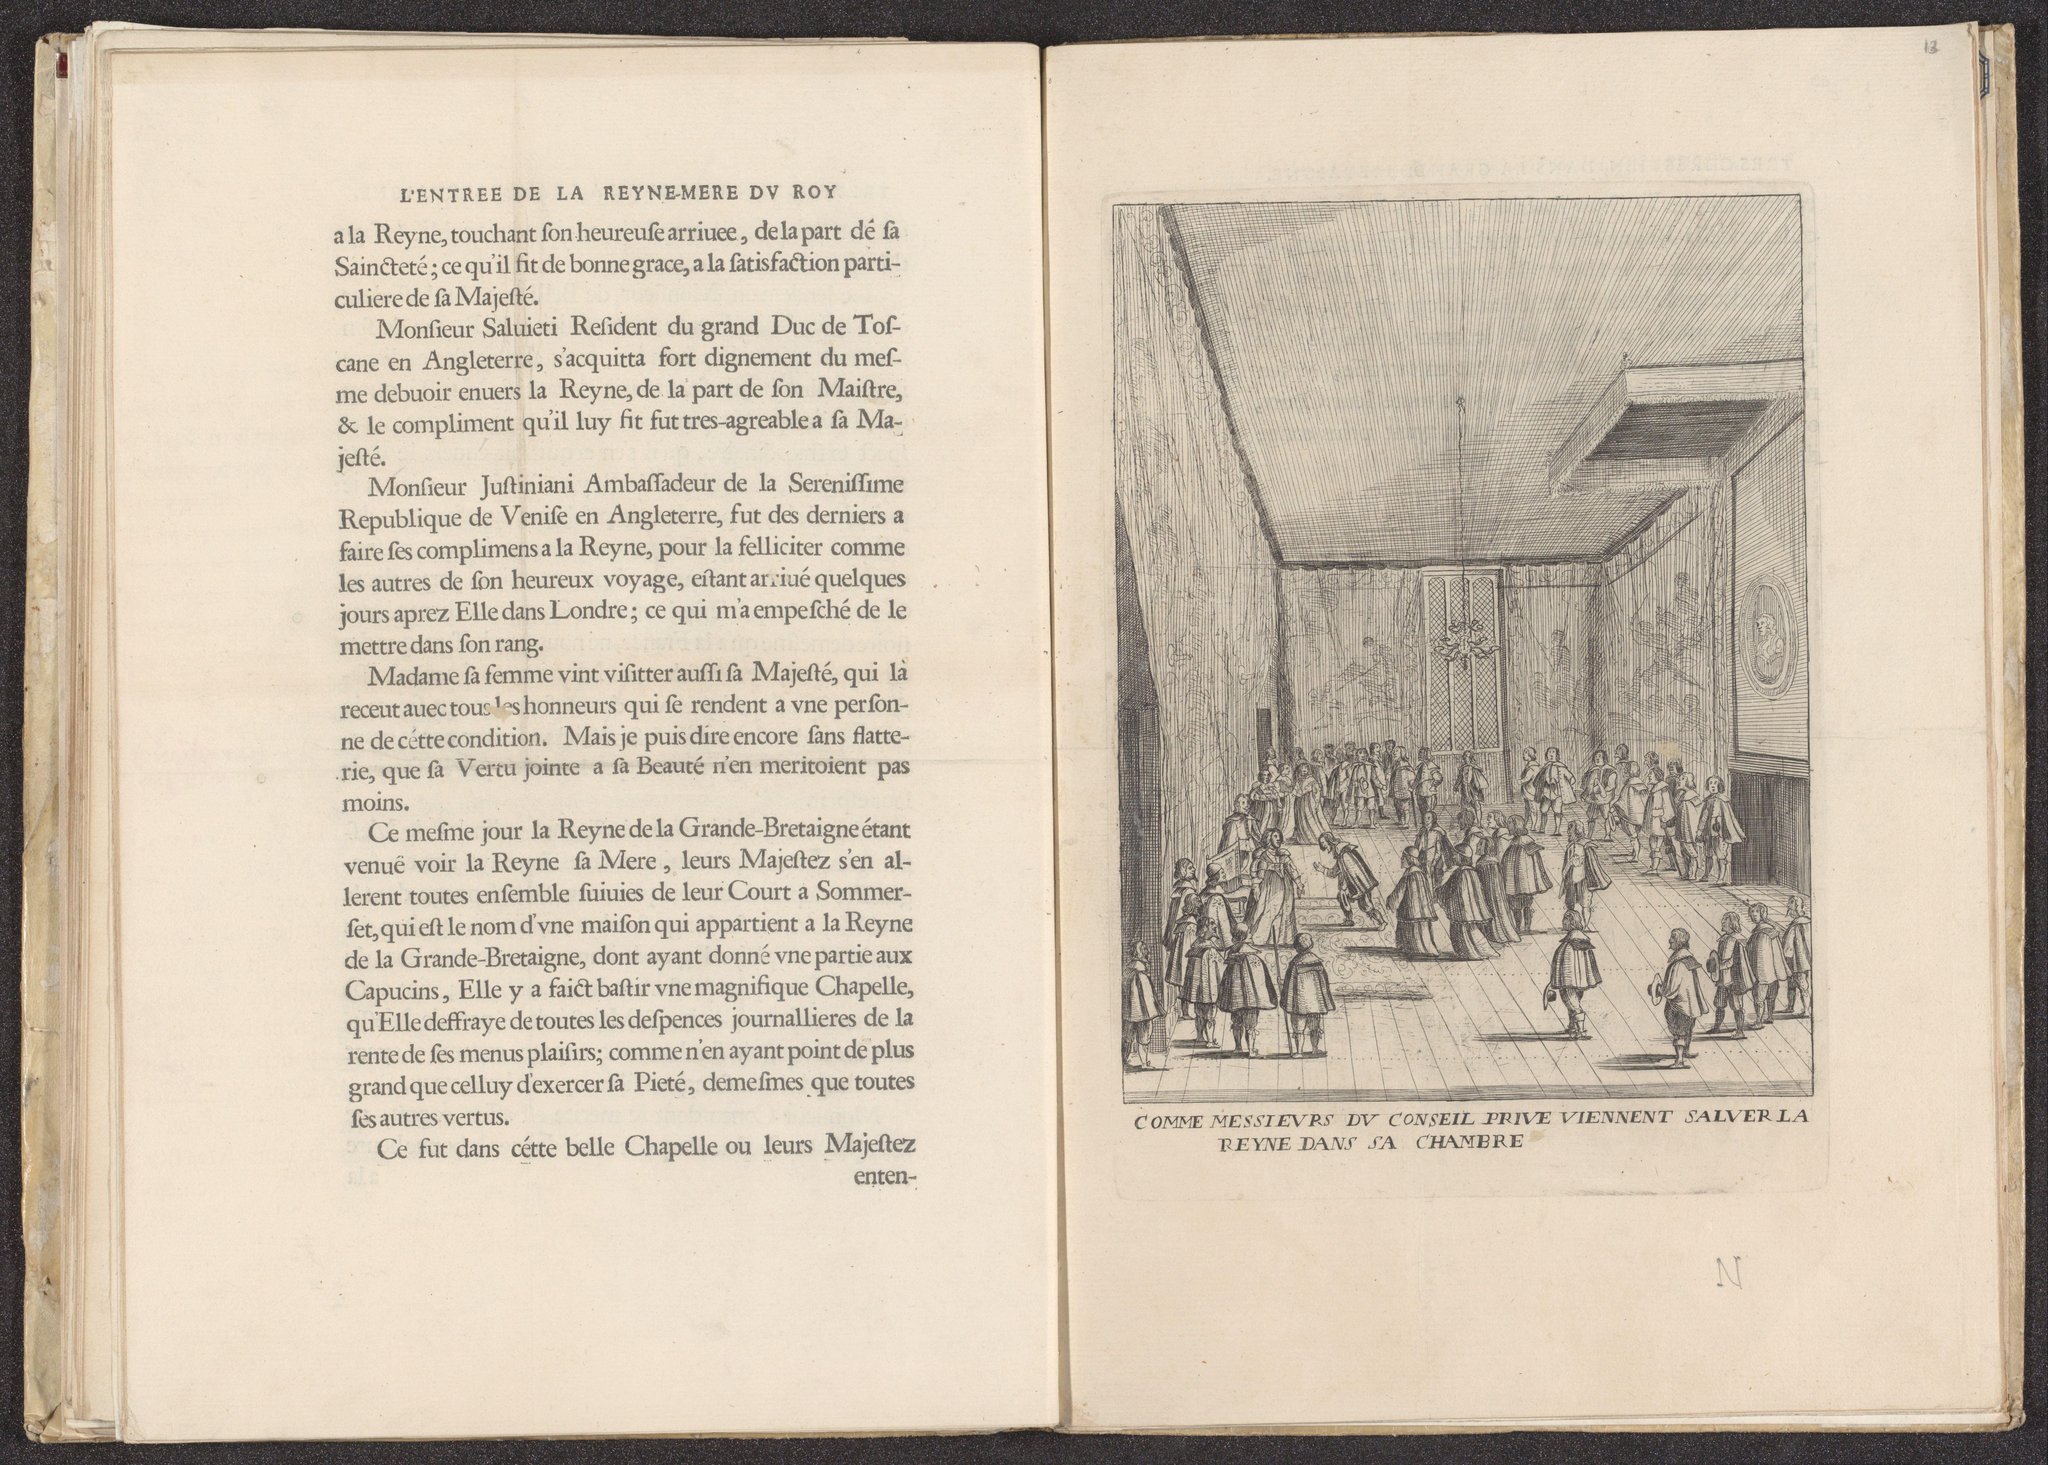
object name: history print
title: Maria de' Medici ontvangt raadslieden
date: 1639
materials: paper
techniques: etching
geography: london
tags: cologne, print maker, maria de' medici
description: In een kamer met wandtapijten en een rechts een portret aan de muur, ontvangt Maria de' Medici verschillende raadslieden. De prent maakt deel uit van een boek over de ontvangst van de Franse koning-moeder Maria de' Medici aan Engeland.